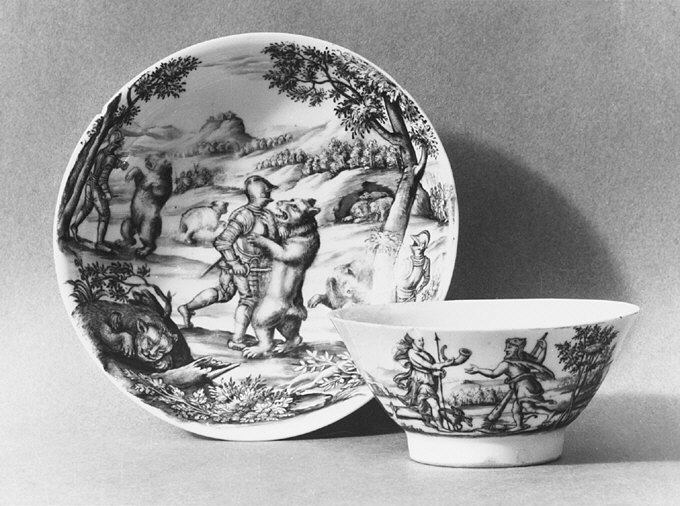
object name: teabowl and saucer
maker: vienna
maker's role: manufactory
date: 1720-1730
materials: hard paste porcelain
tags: bears,armor